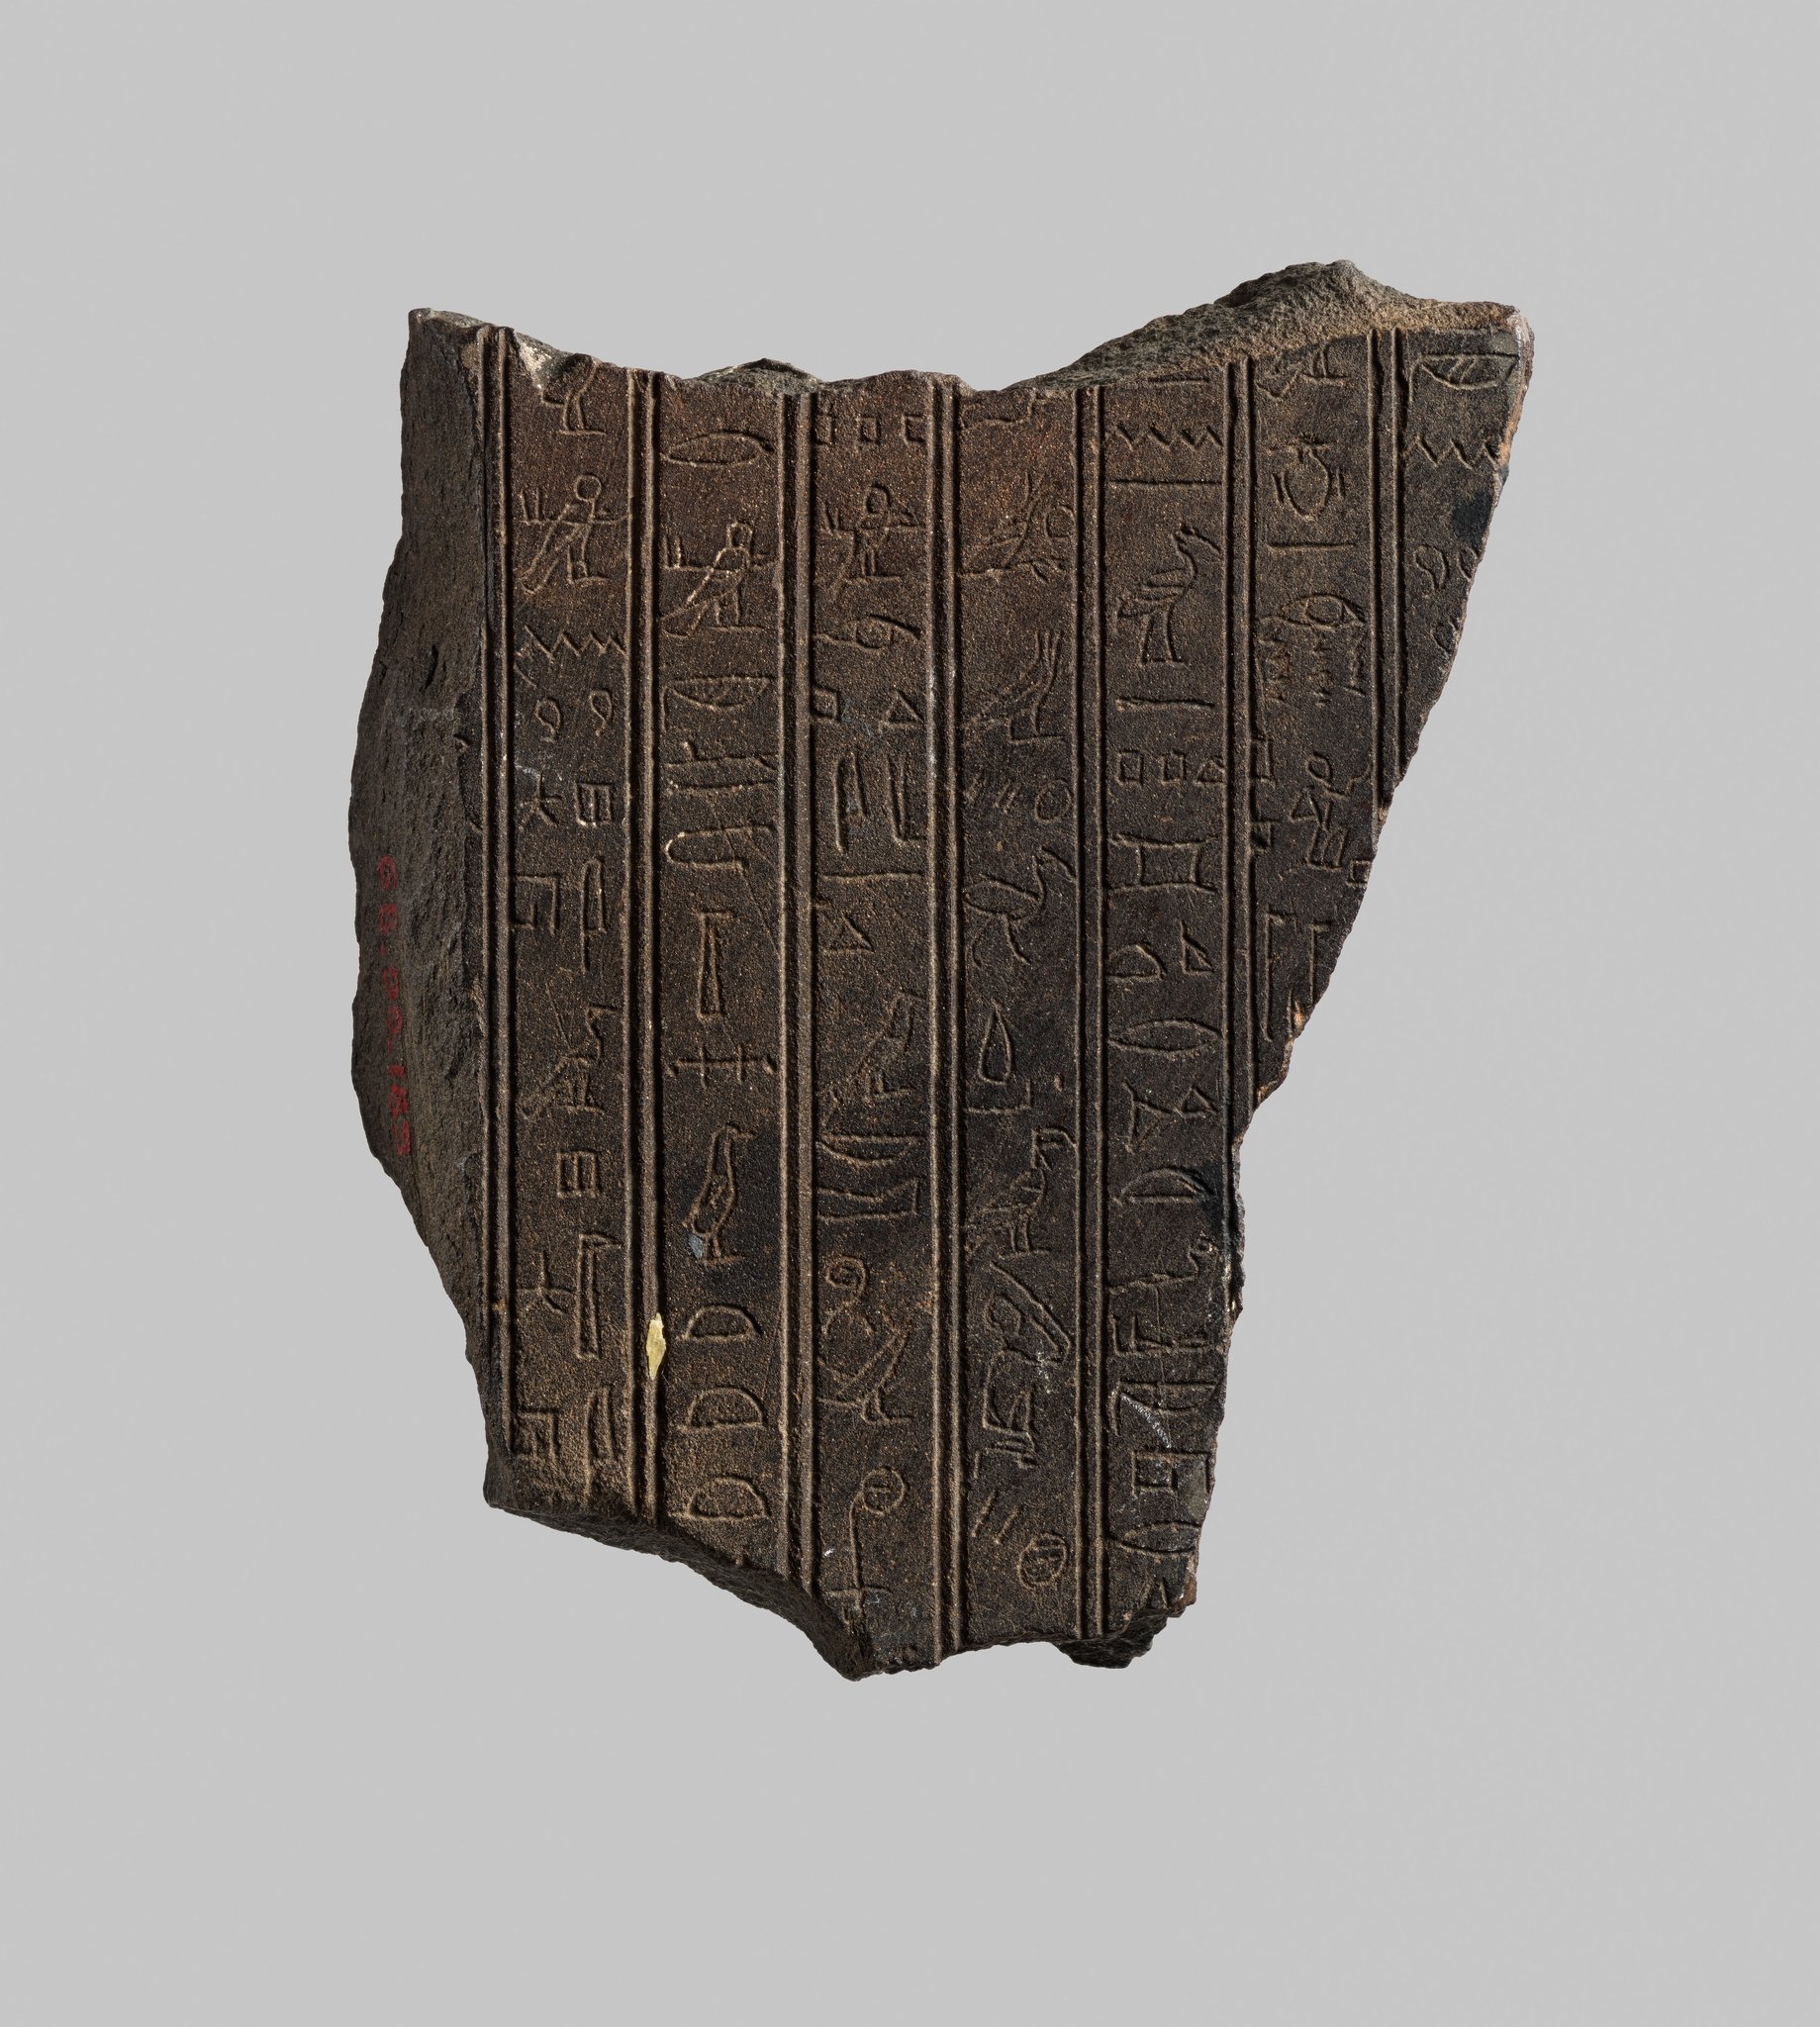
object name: stela of a polymorphic god, be pantheos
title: Stela of a polymorphic god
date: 664-332 BCE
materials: stone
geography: egypt